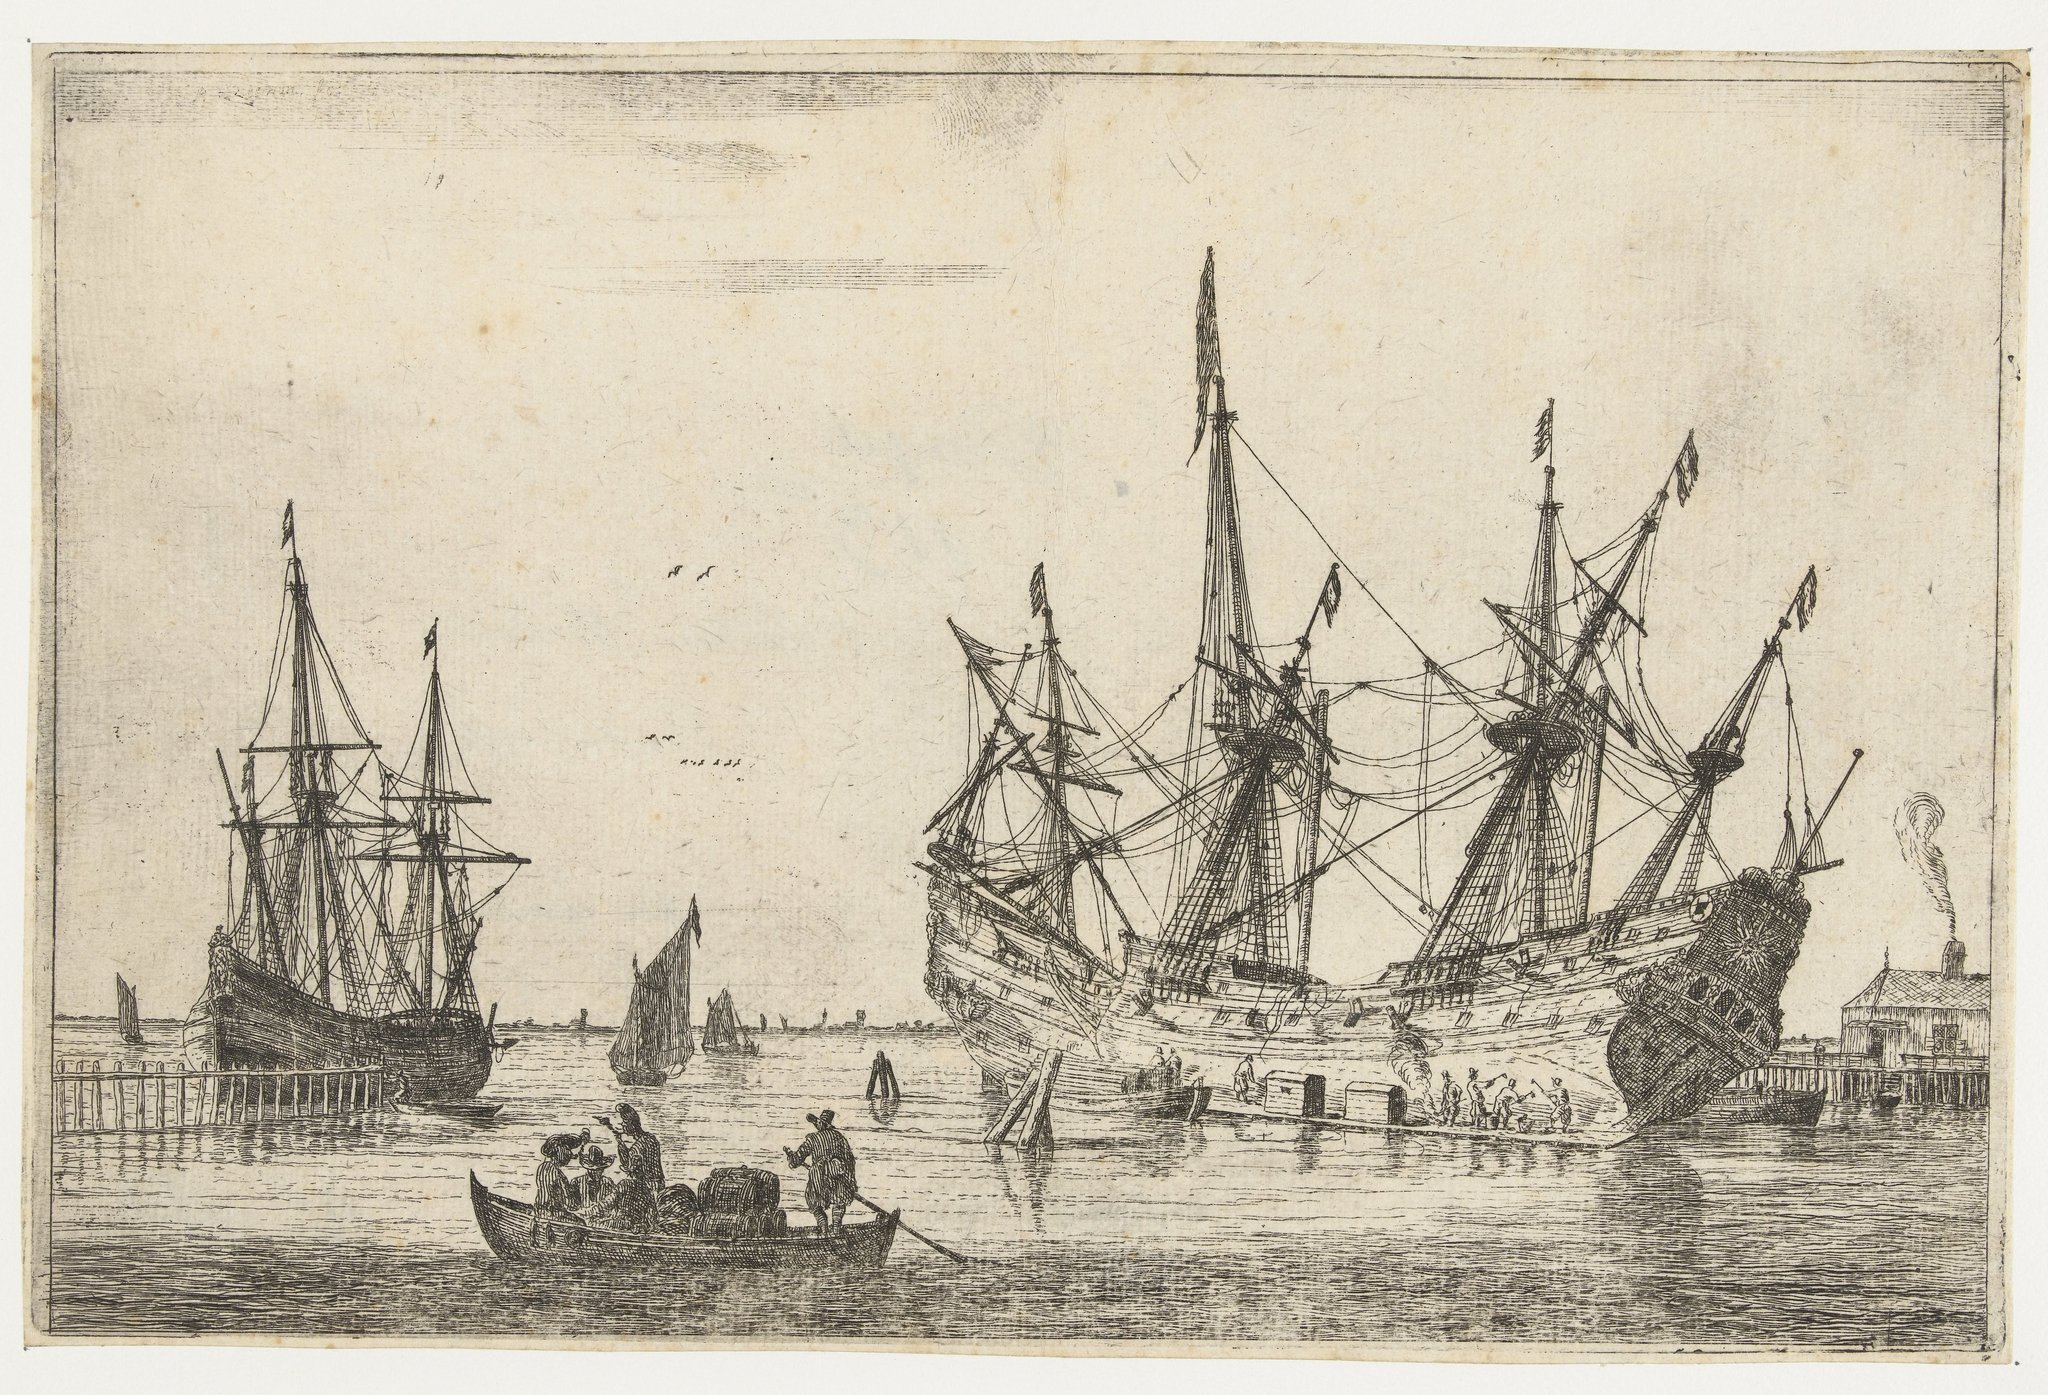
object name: print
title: Waterdichtmaken van de romp van een schip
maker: reinier nooms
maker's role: draughtsman, painter, print maker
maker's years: 1623-1664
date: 1650-1664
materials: paper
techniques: etching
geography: netherlands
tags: repairing, caulking, careening (~ ship)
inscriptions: collector's mark: Lugt 2228a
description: Een groot zeilschip ligt gekield in een werf. Mannen op een vlot werken aan de romp van het schip. In de haven tweede zeilschip, een roeiboot met passagiers en een fluitschip bij een golfbreker.